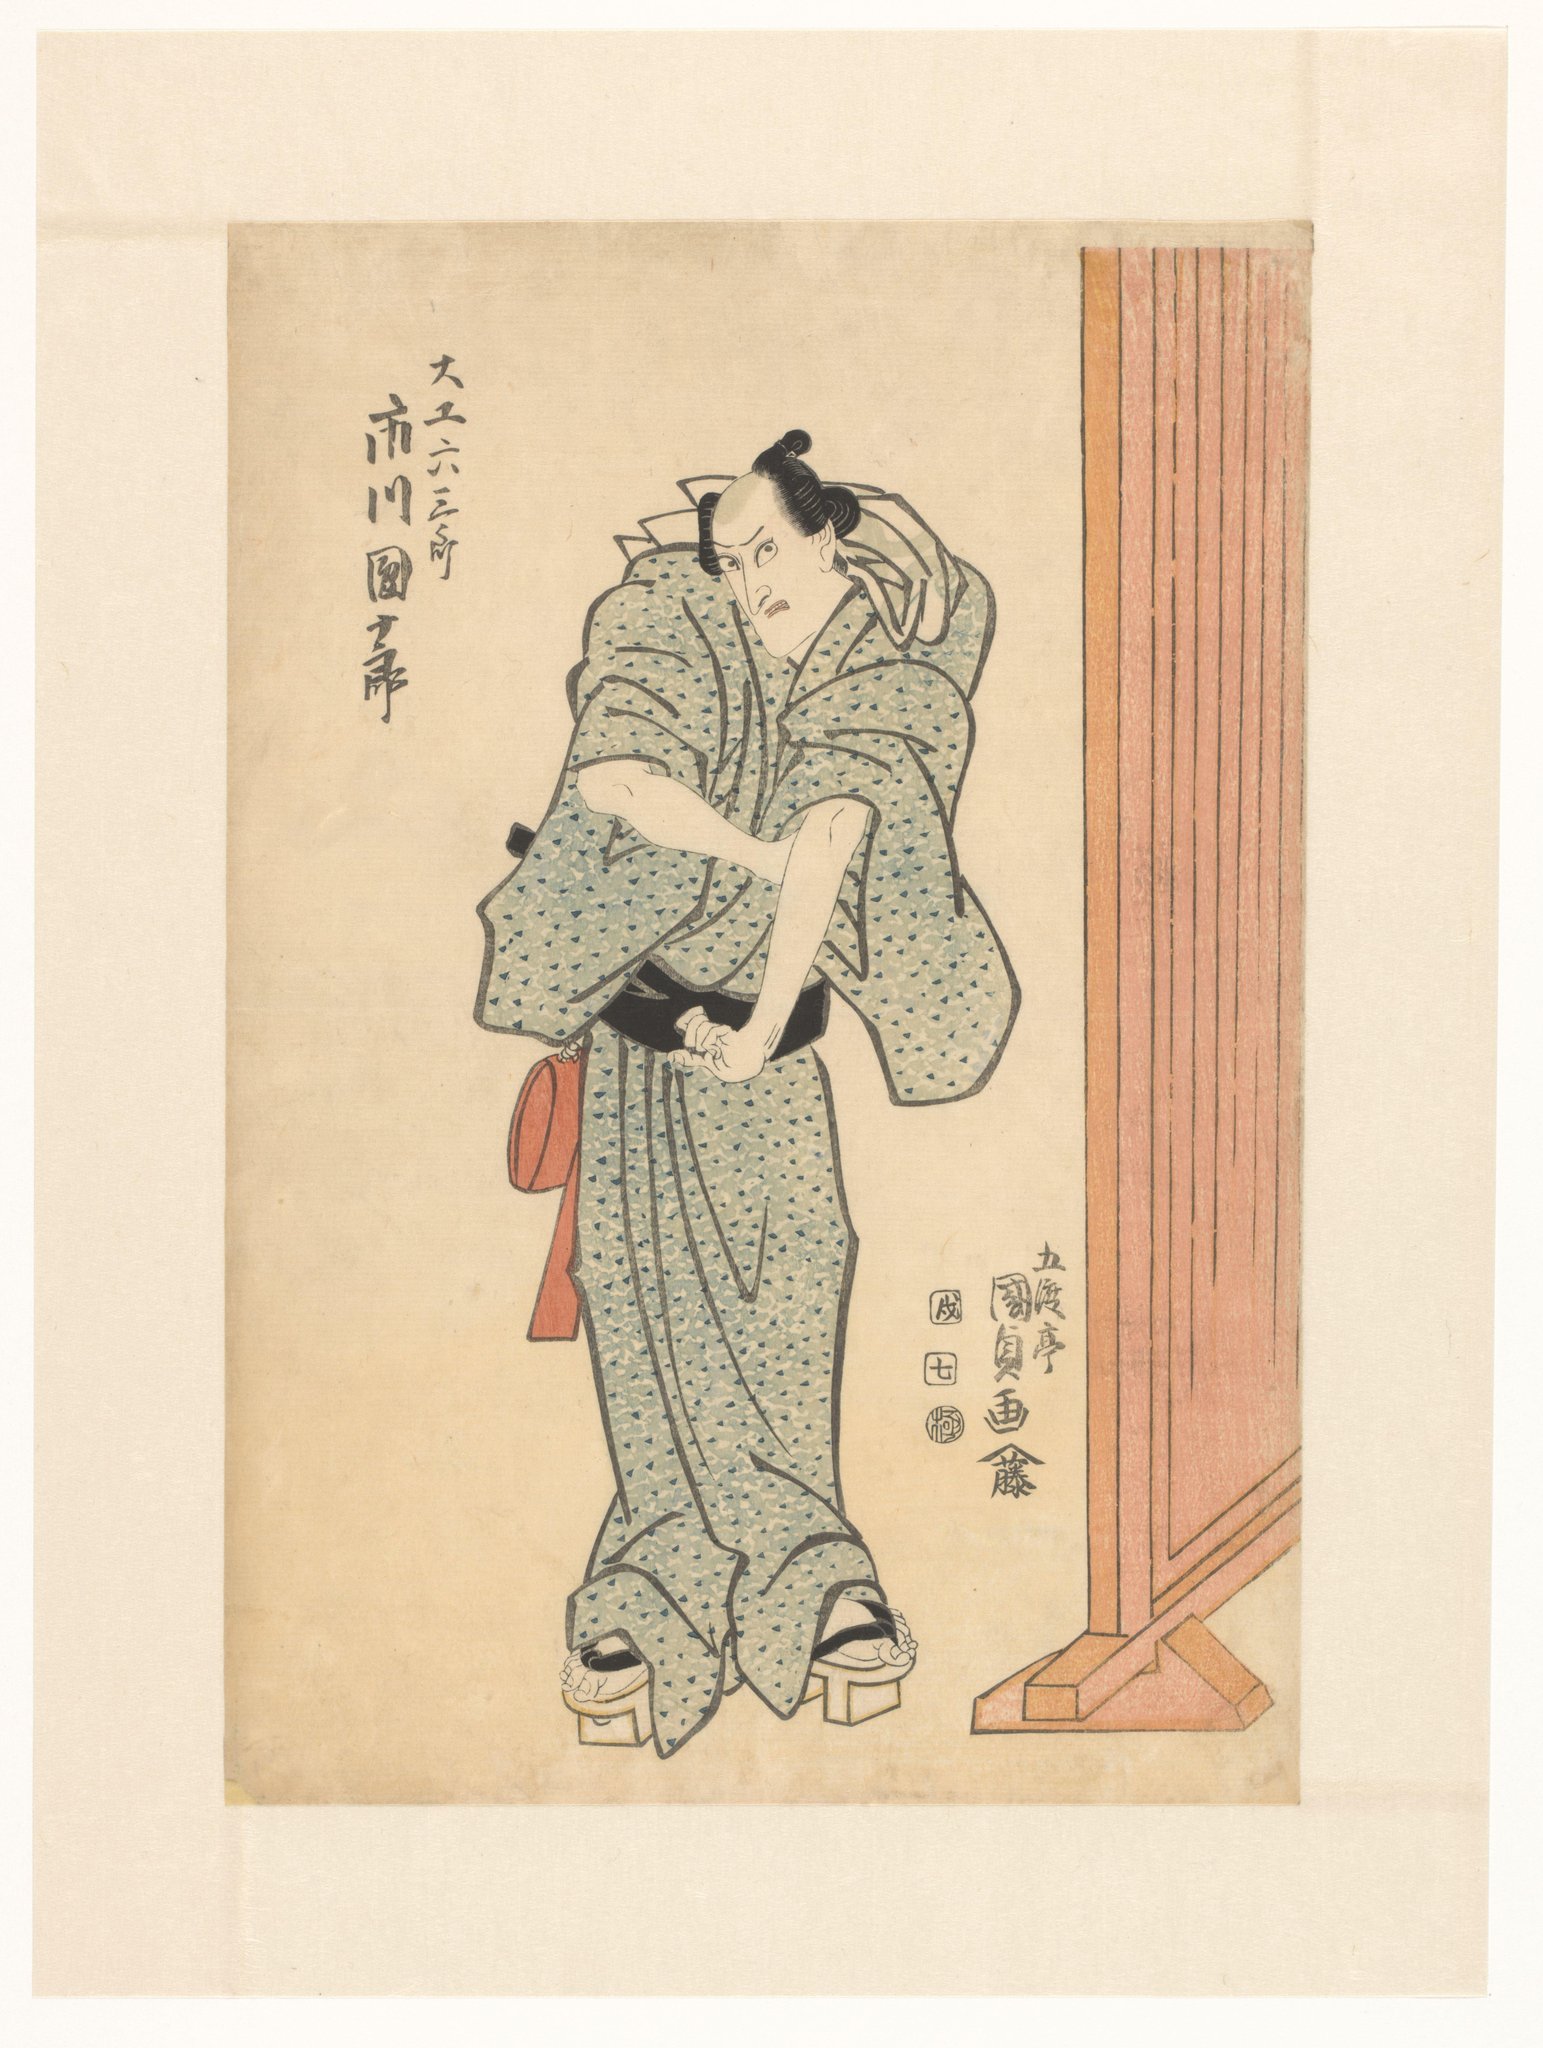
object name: print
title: Carpenter Rokusaburô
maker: utagawa kunisada (i)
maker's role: print maker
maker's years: 1786-1865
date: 1807-1814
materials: paper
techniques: woodcut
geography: japan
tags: door, actor (on the stage)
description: Kabuki acteur Ichikawa Danjurô VII als timmerman Rokusaburô. Hij is gekleed in een zomer kimono en staat naast een houten poort die toegang geeft tot een huis.